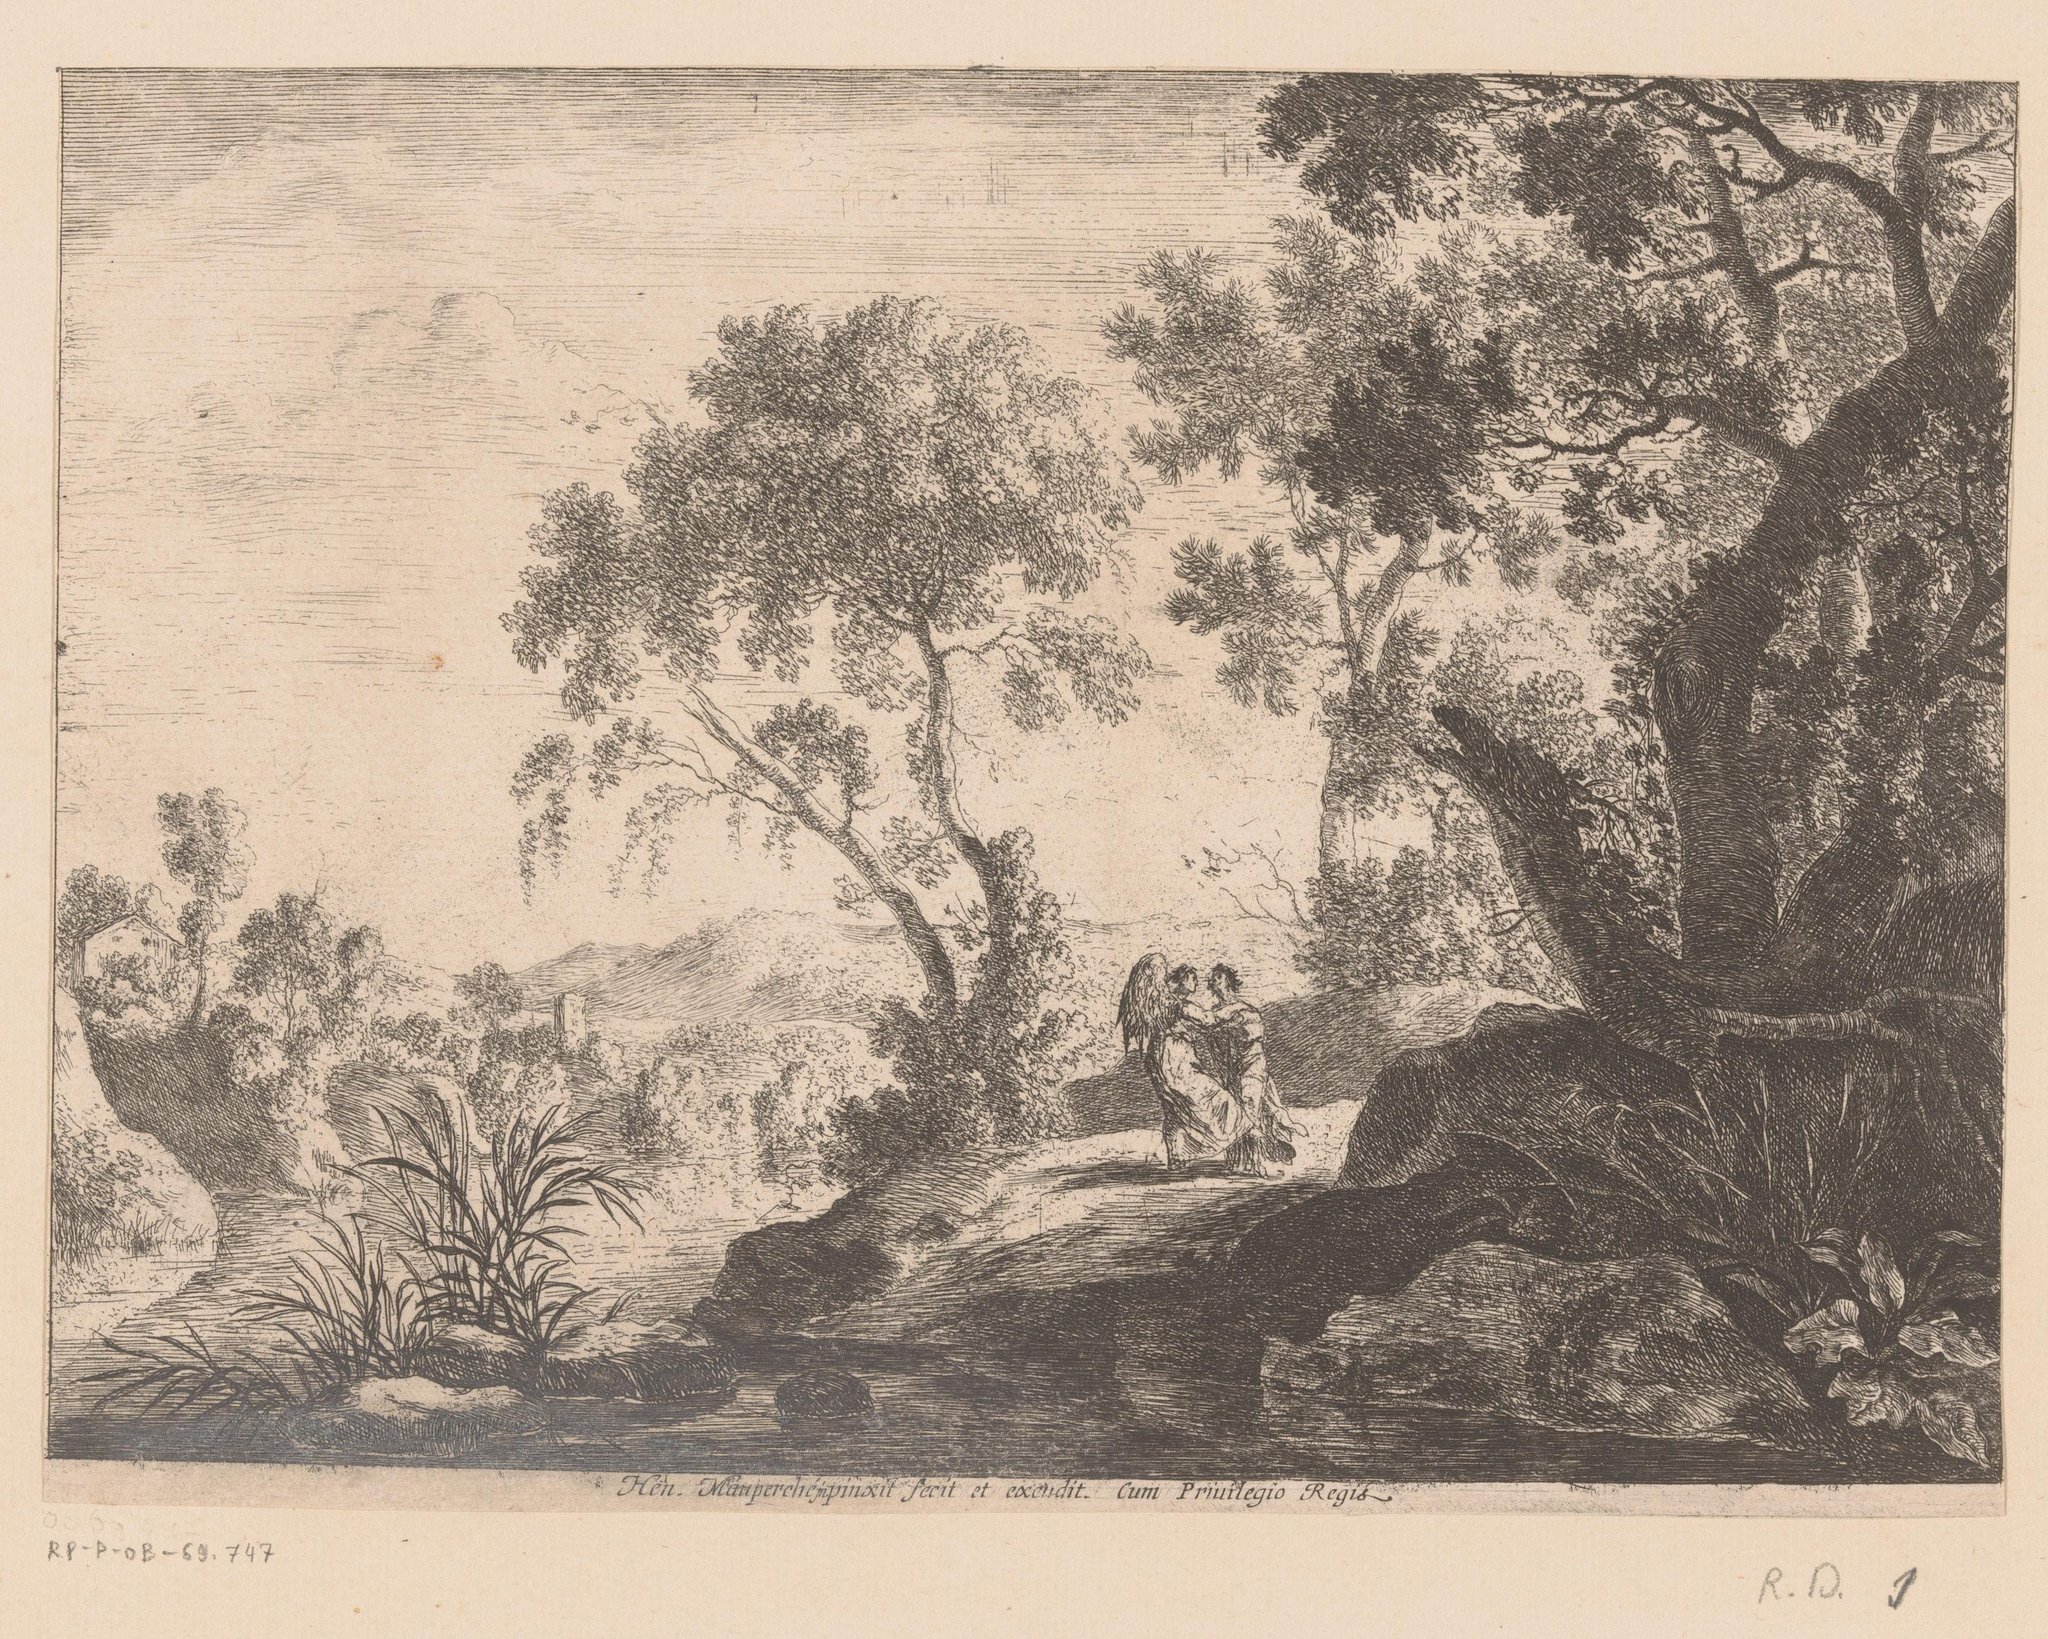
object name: print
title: Jakob vecht met de engel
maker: henri mauperché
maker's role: painter, print maker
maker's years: 1602-1686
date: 1612-1686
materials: paper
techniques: etching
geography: paris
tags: jacob wrestles with the angel (or man) till daybreak; jacob's thigh is put out of joint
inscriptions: collector's mark: Lugt 240